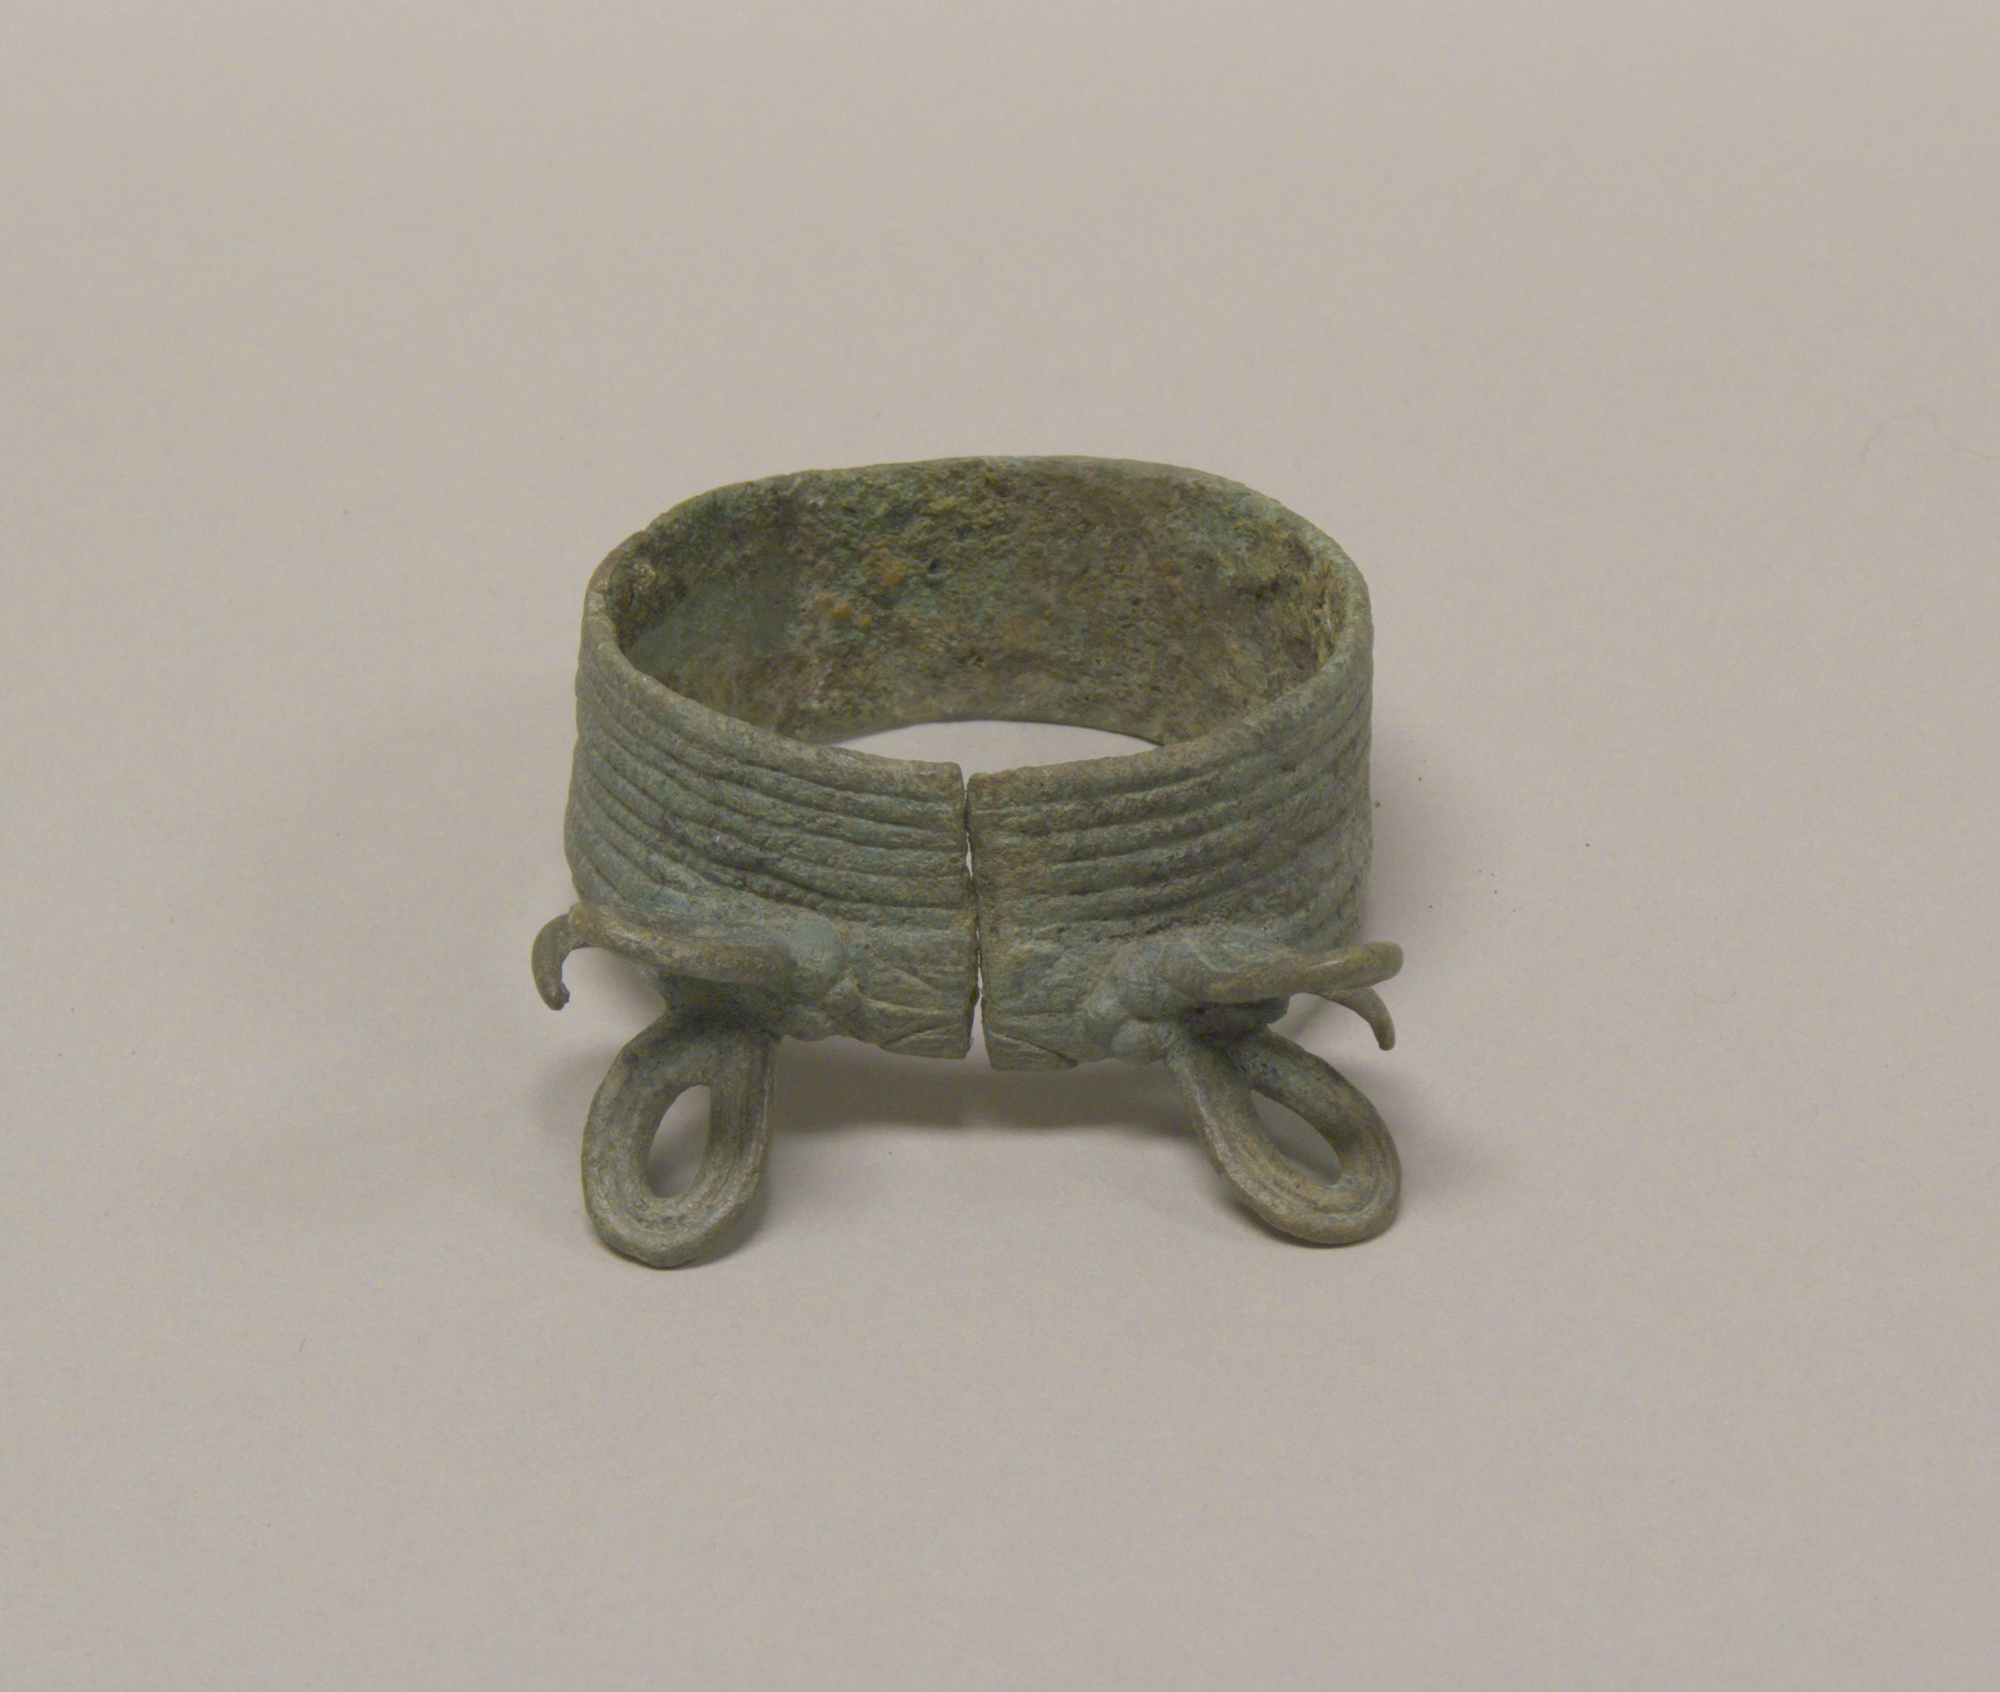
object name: bracelet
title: Bracelet with Two Facing Dragonflies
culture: thai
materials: bronze